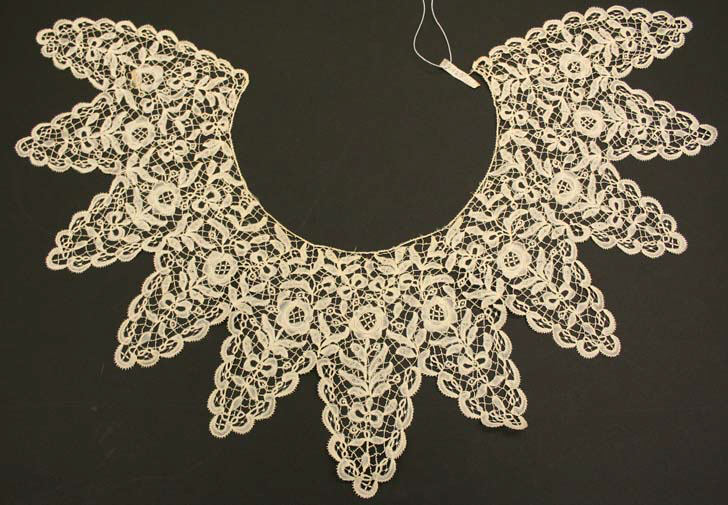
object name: collar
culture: british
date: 1801-1900